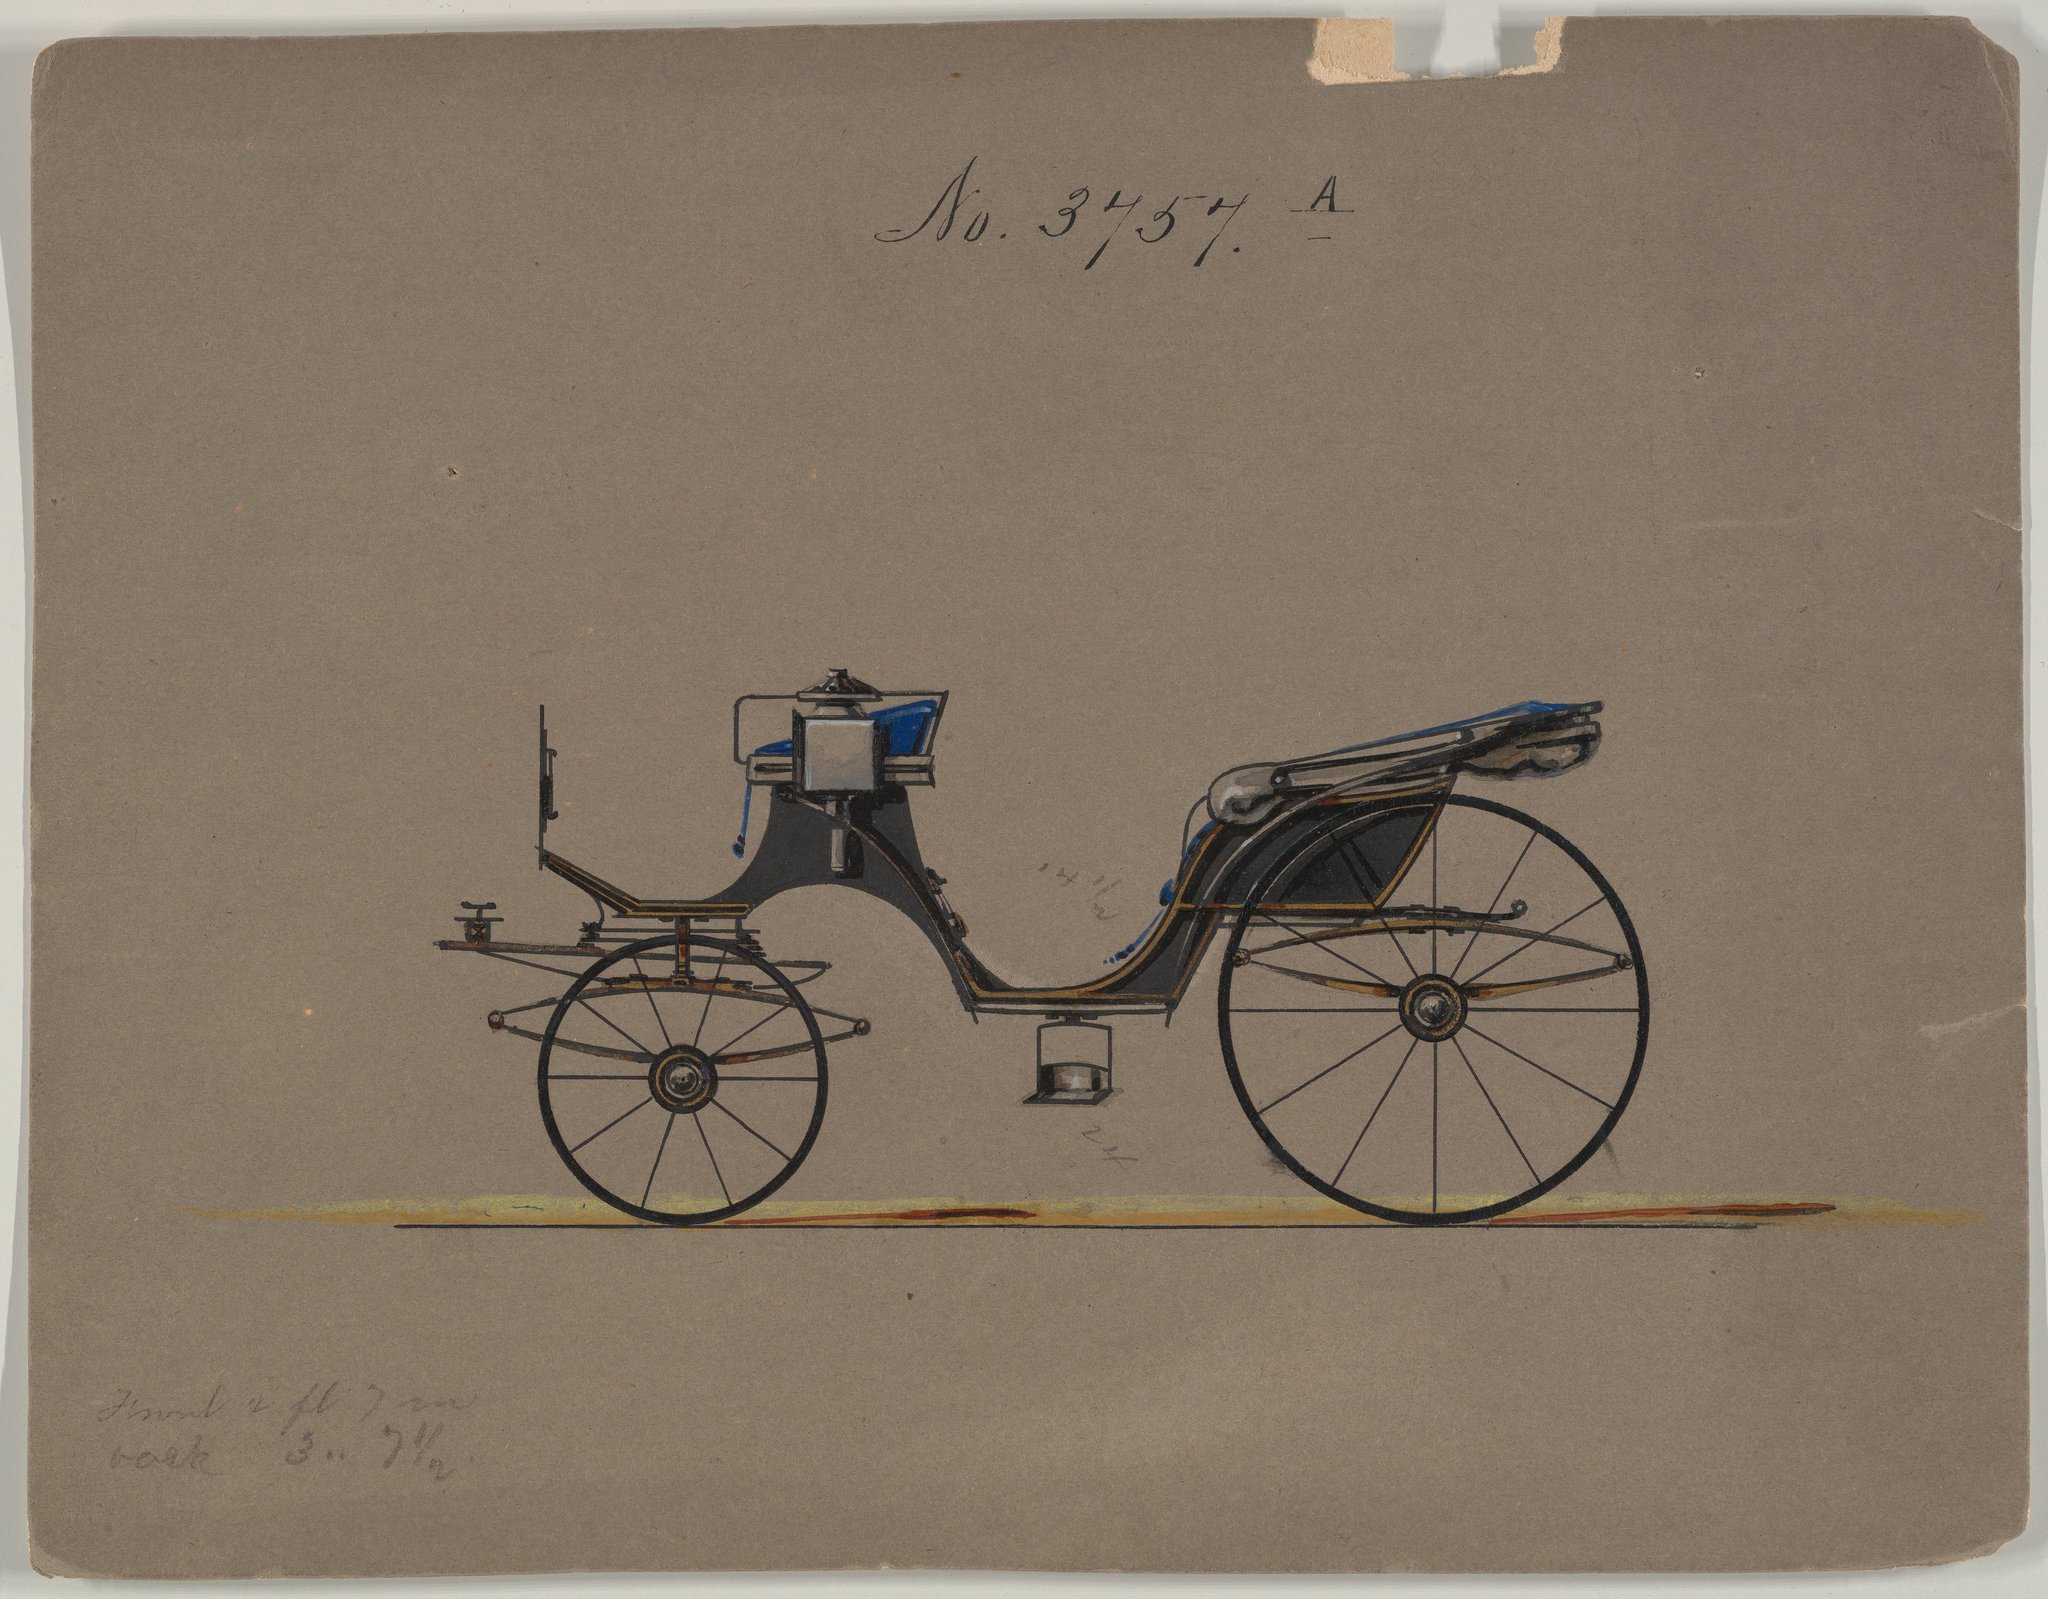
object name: drawing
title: Design for Cabriolet or Victoria, no. 3757a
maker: brewster & co.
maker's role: manufacturer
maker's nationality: american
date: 1882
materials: gouache, ink, watercolor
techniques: pen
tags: carriages